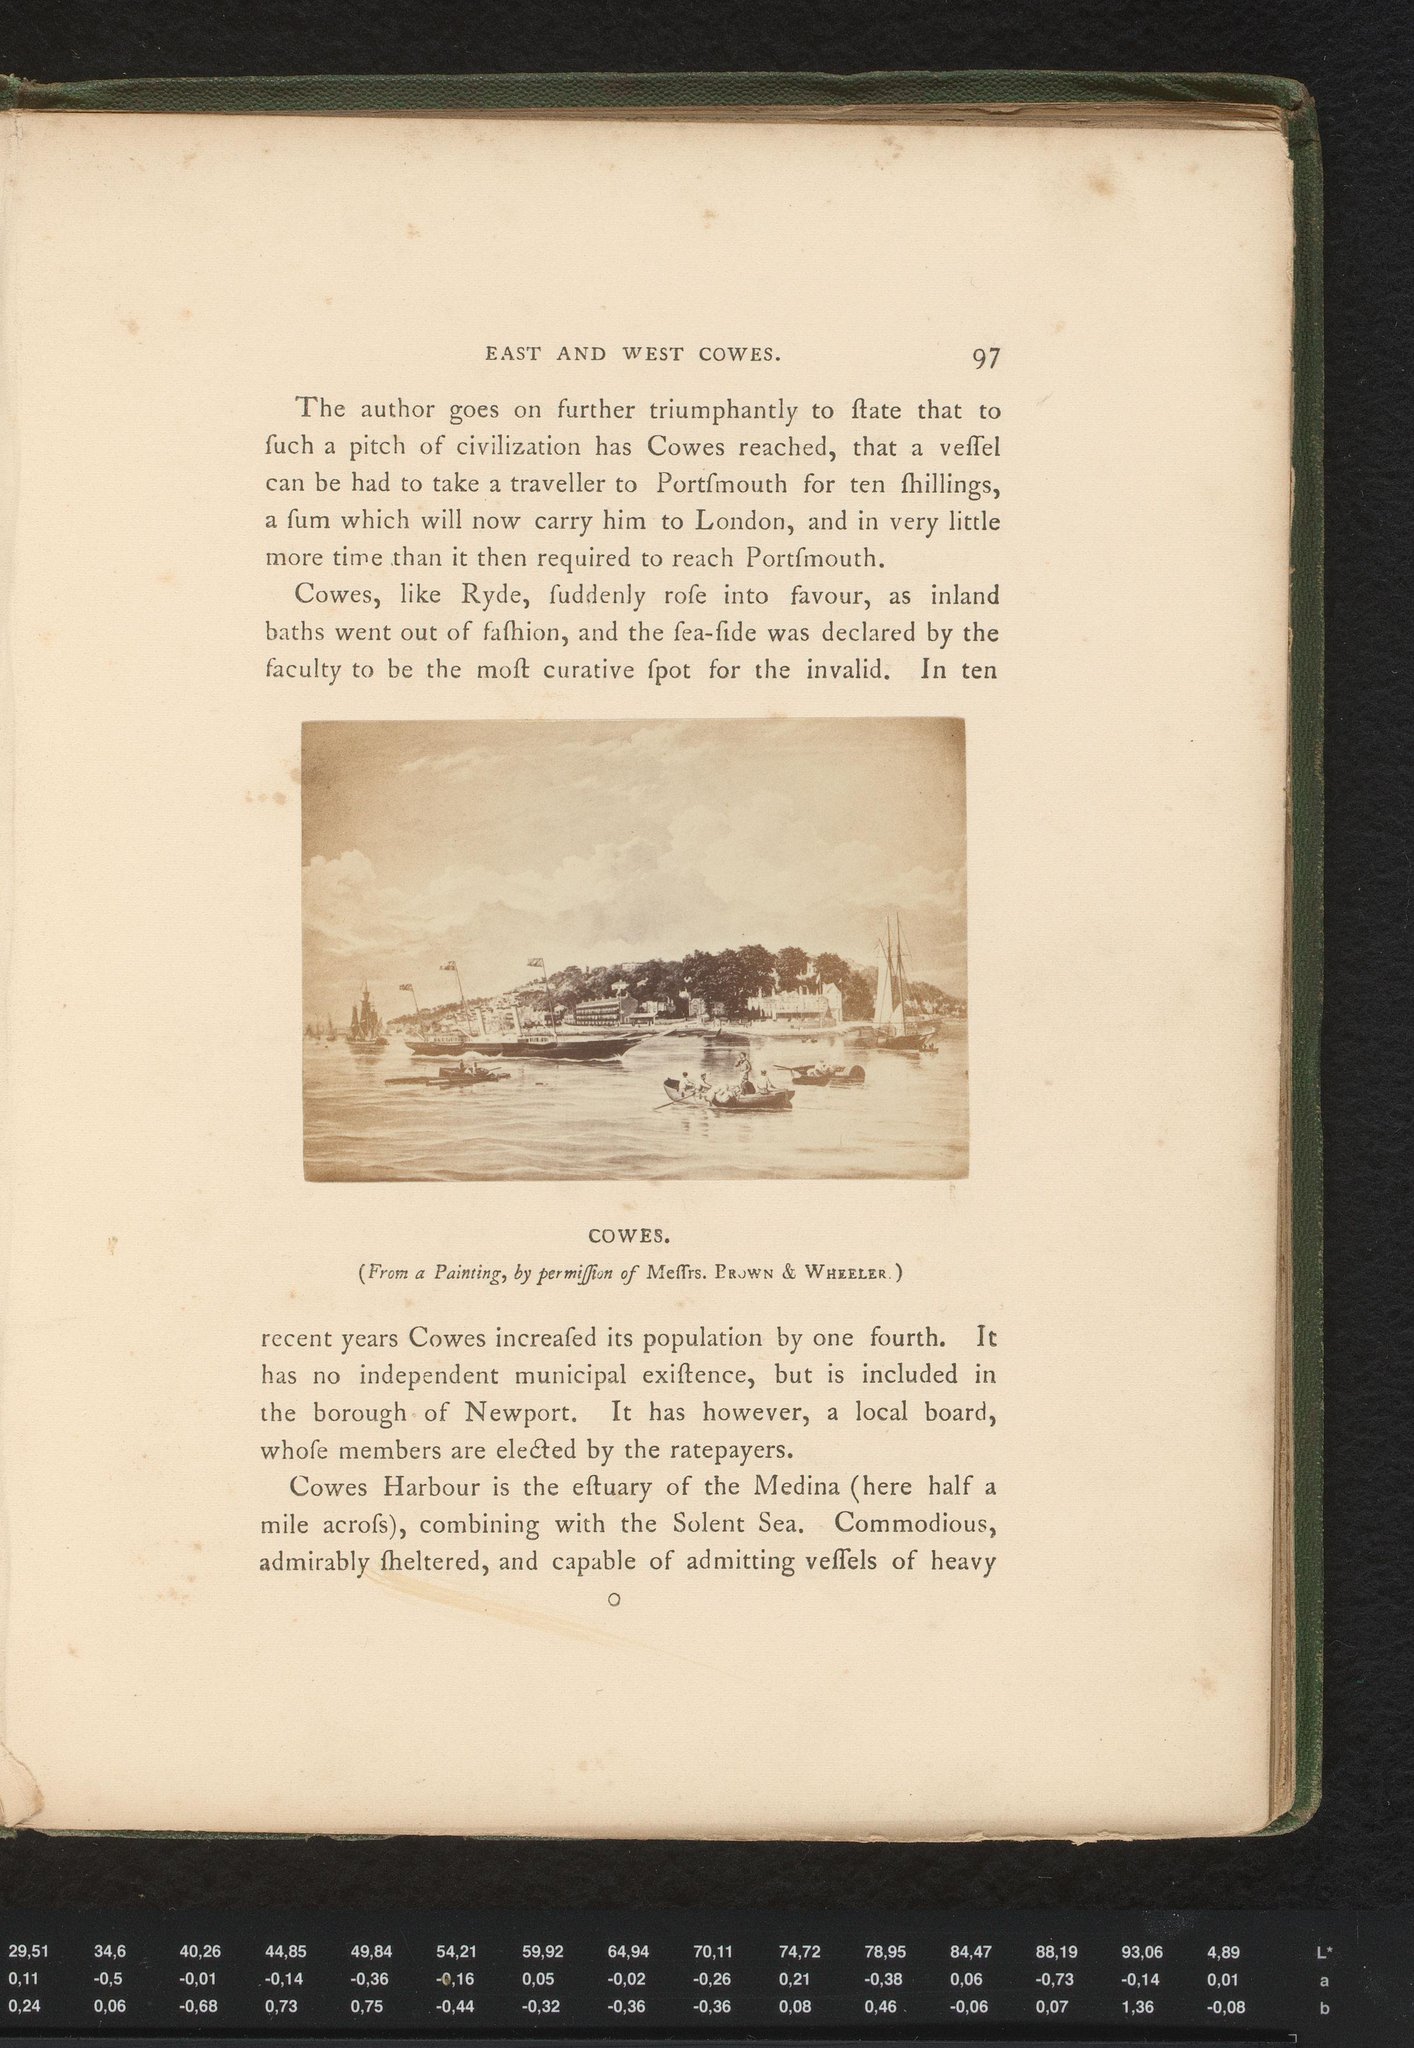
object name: page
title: Fotoreproductie van een schilderij, voorstellende een gezicht op Cowes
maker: Anonymous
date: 1864-1869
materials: paper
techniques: albumen print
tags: city-view in general; 'veduta', cowes